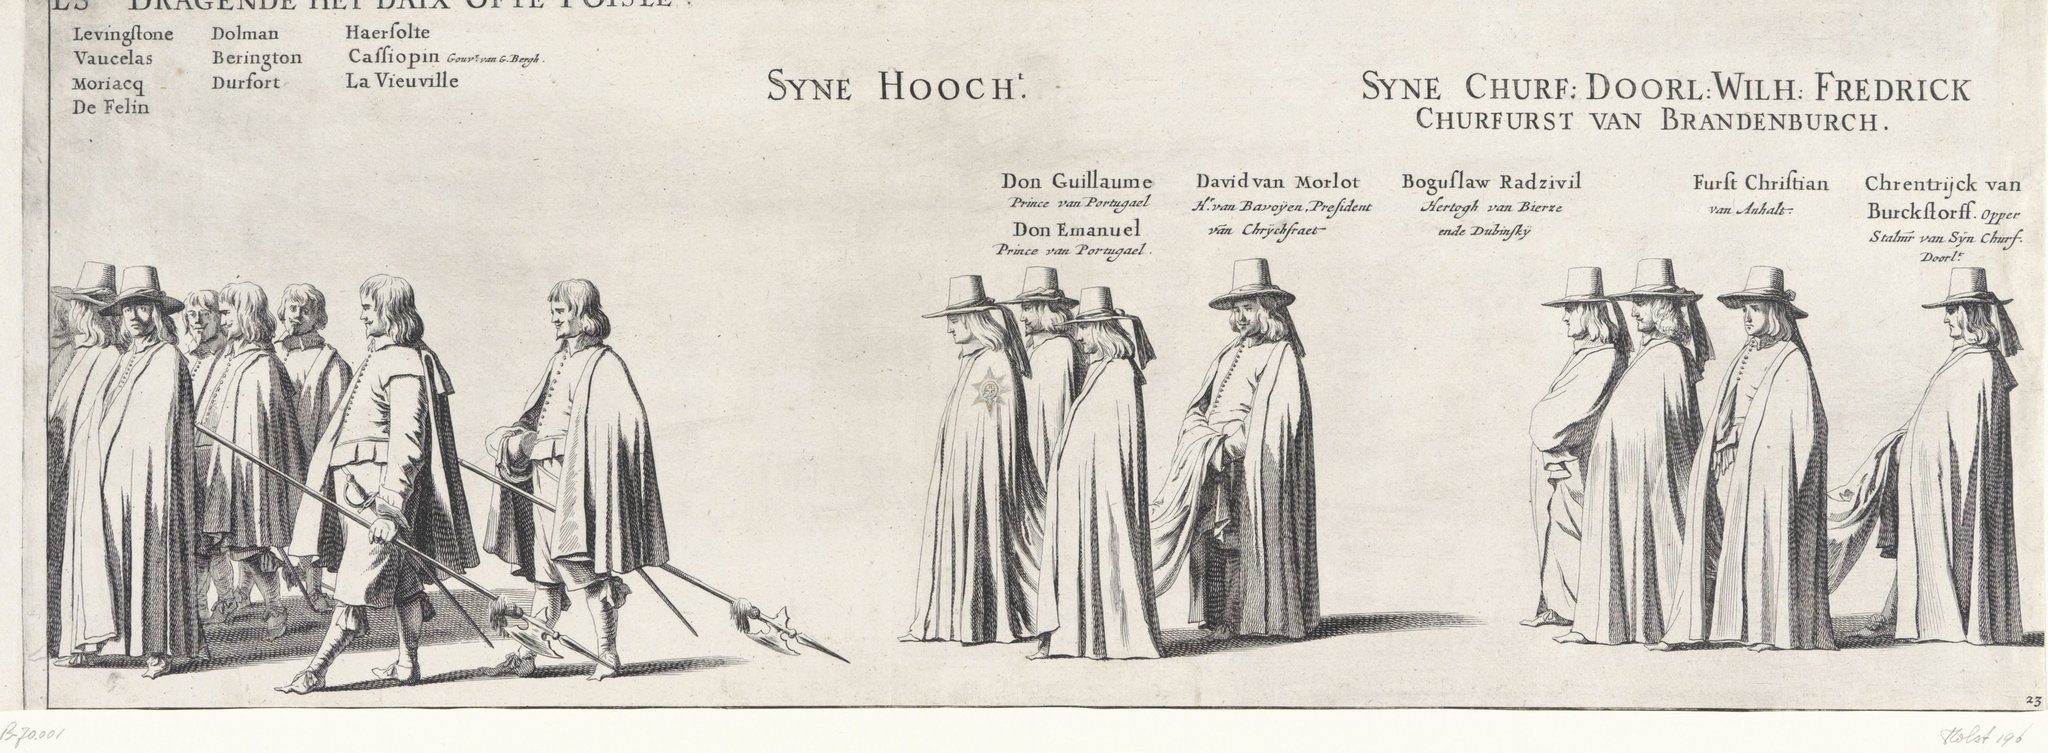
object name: print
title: De begrafenisstoet van stadhouder Frederik Hendrik te 's-Gravenhage in 1647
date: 1647-1651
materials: paper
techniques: etching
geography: amsterdam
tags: delft, the hague, frederick henry (prince of orange), cortege, funeral procession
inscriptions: collector's mark: Lugt 2228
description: De begrafenisstoet van stadhouder Frederik Hendrik te 's-Gravenhage op 10 mei 1647. Plaat nr. 23 met een deel van de stoet, boven de personen staan hun naam en functie. Een strookje met de naam Frederick Wilh. opgeplakt. Onderdeel van een serie van 30 platen en 20 tekstbladen, bedoeld om aan elkaar geplakt te worden.